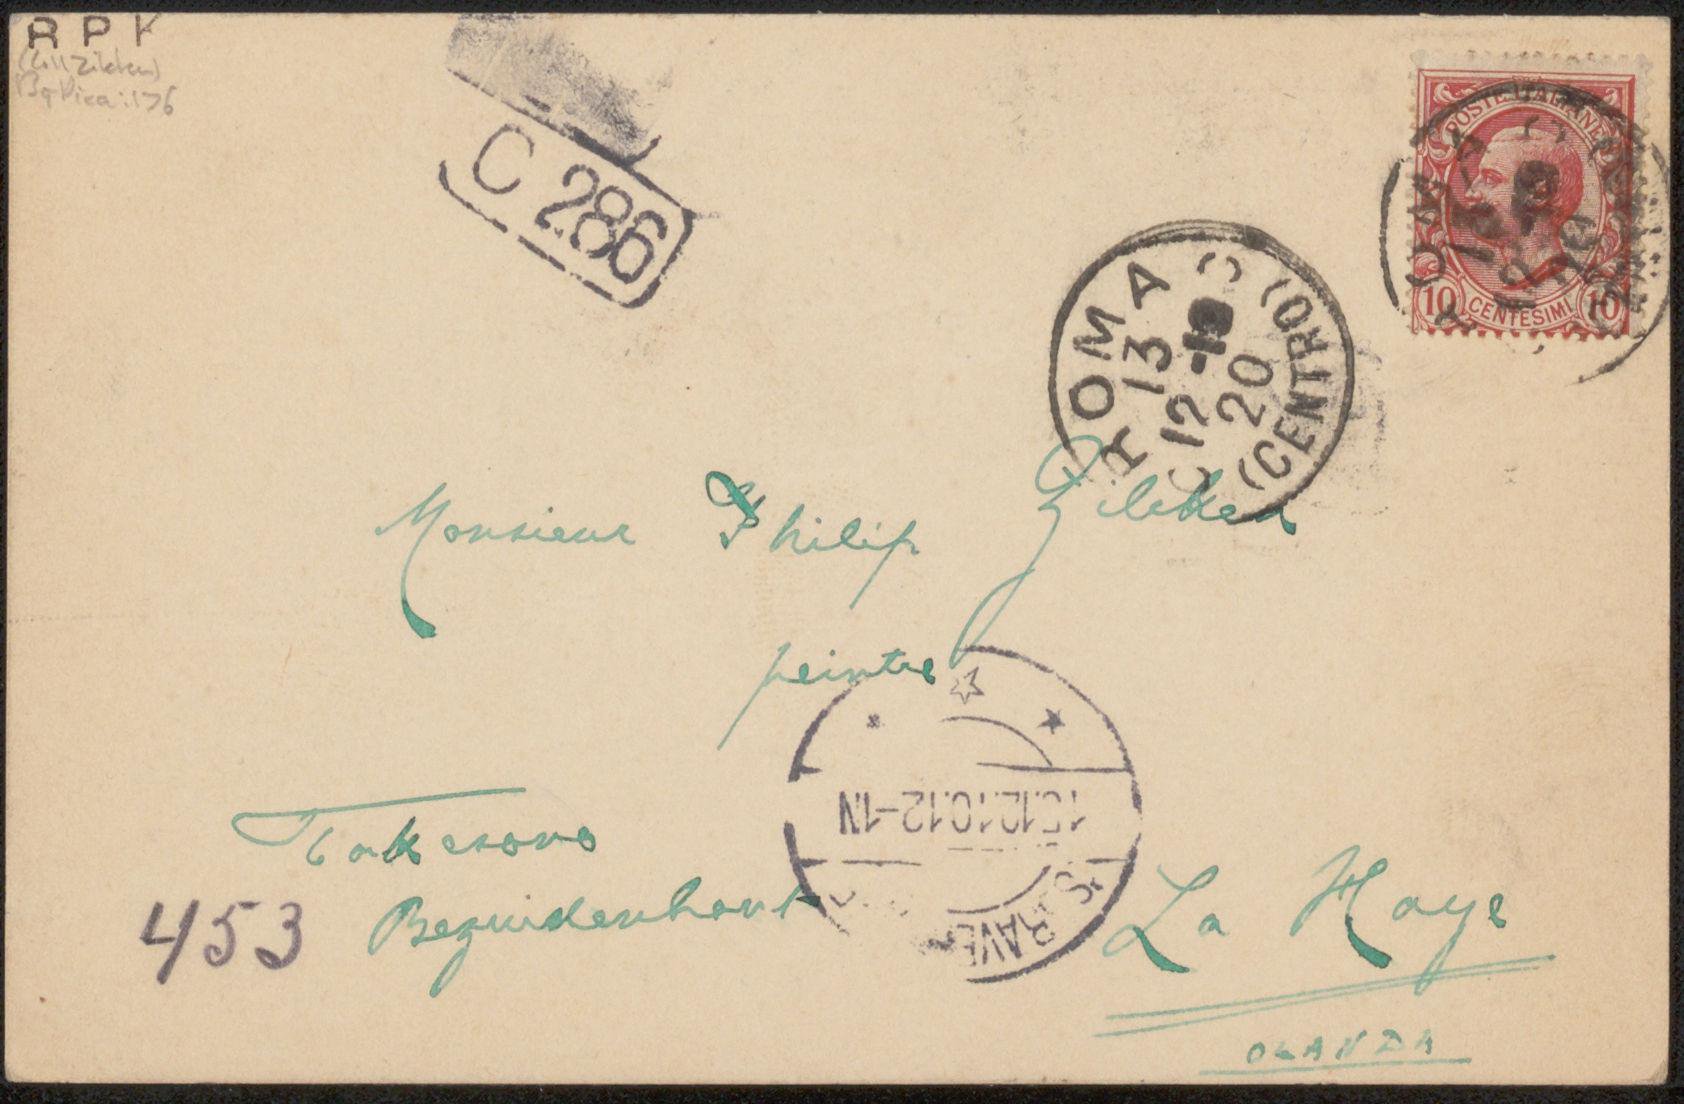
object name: letter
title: Brief aan Philip Zilcken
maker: vittorio pica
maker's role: criticus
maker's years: 1864-1930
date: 1910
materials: cardboard, ink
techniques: pen, printing, writing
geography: rome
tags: print maker, abram george steelink, painter, draughtsman, philip zilcken, exhibition ~ art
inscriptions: collector's mark: ‘RPK’